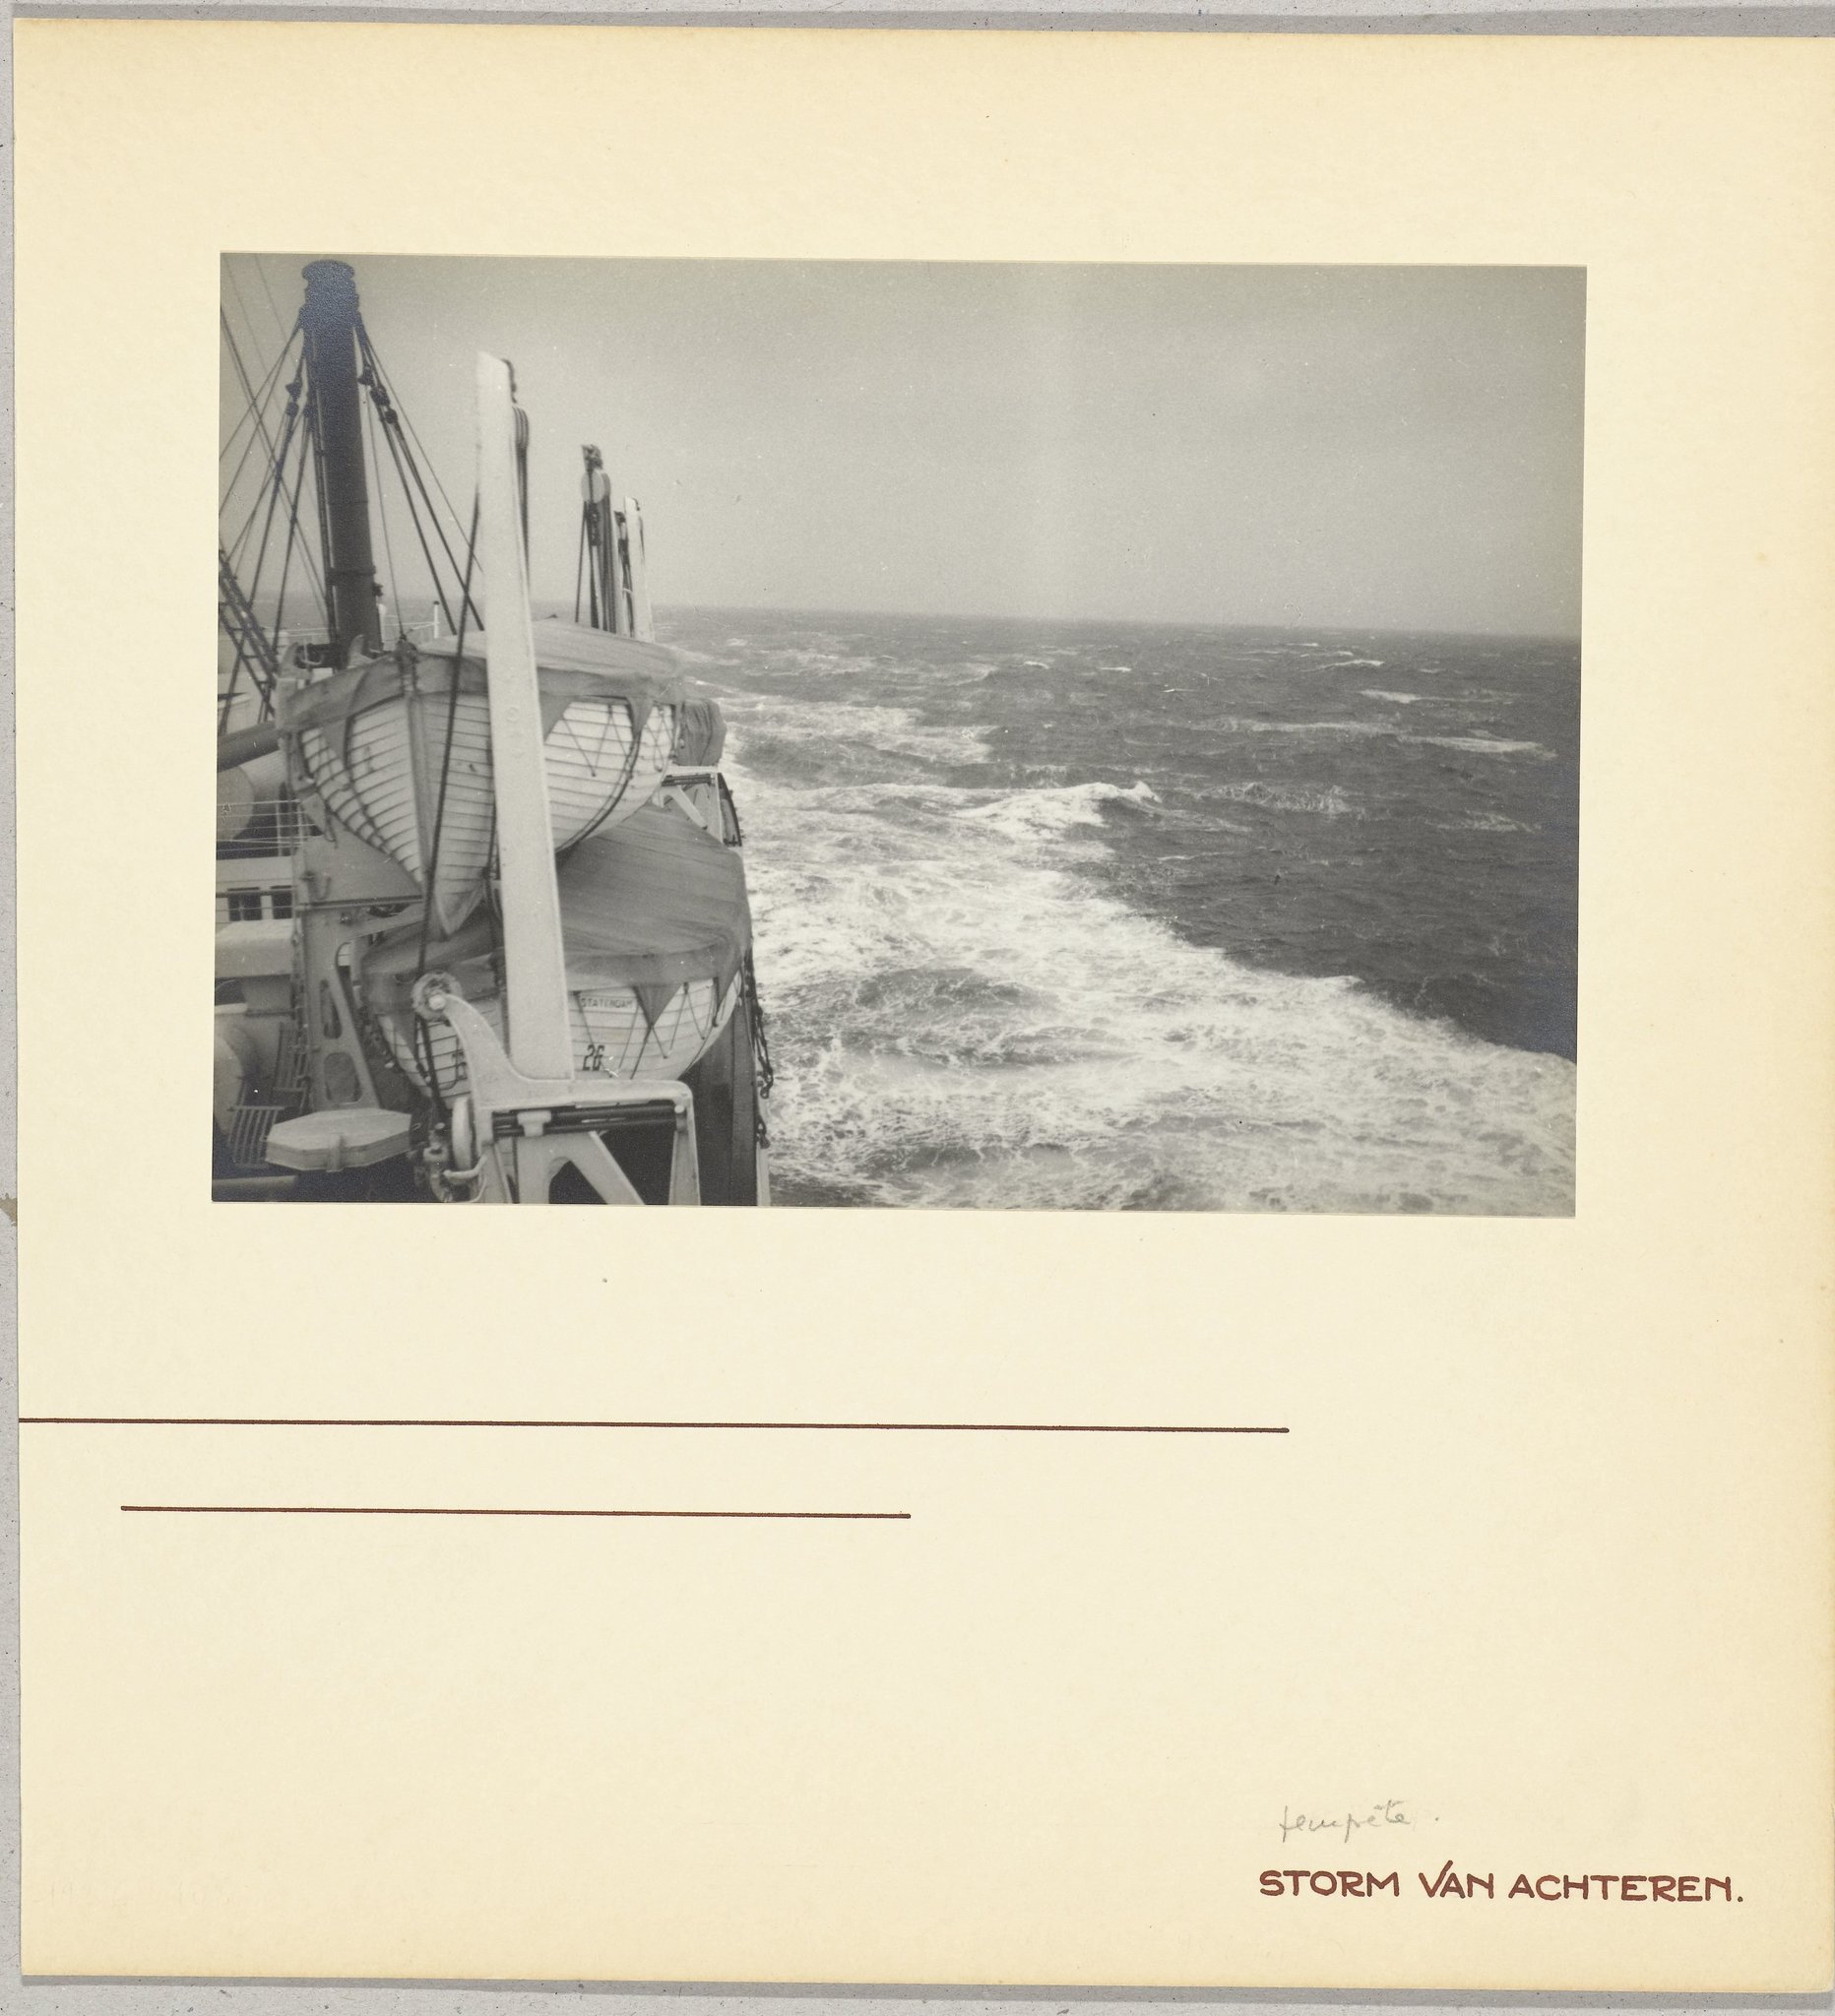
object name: photograph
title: Tijdens de overtocht van Frankrijk naar de Verenigde Staten, Atlantische Oceaan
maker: wouter cool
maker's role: engineer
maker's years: 1877-1947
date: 1936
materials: cardboard, paper, photographic support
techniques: gelatin silver print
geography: united states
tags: steamship, motorship, atlantic ocean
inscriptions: title: ‘STORM VAN ACHTEREN.’